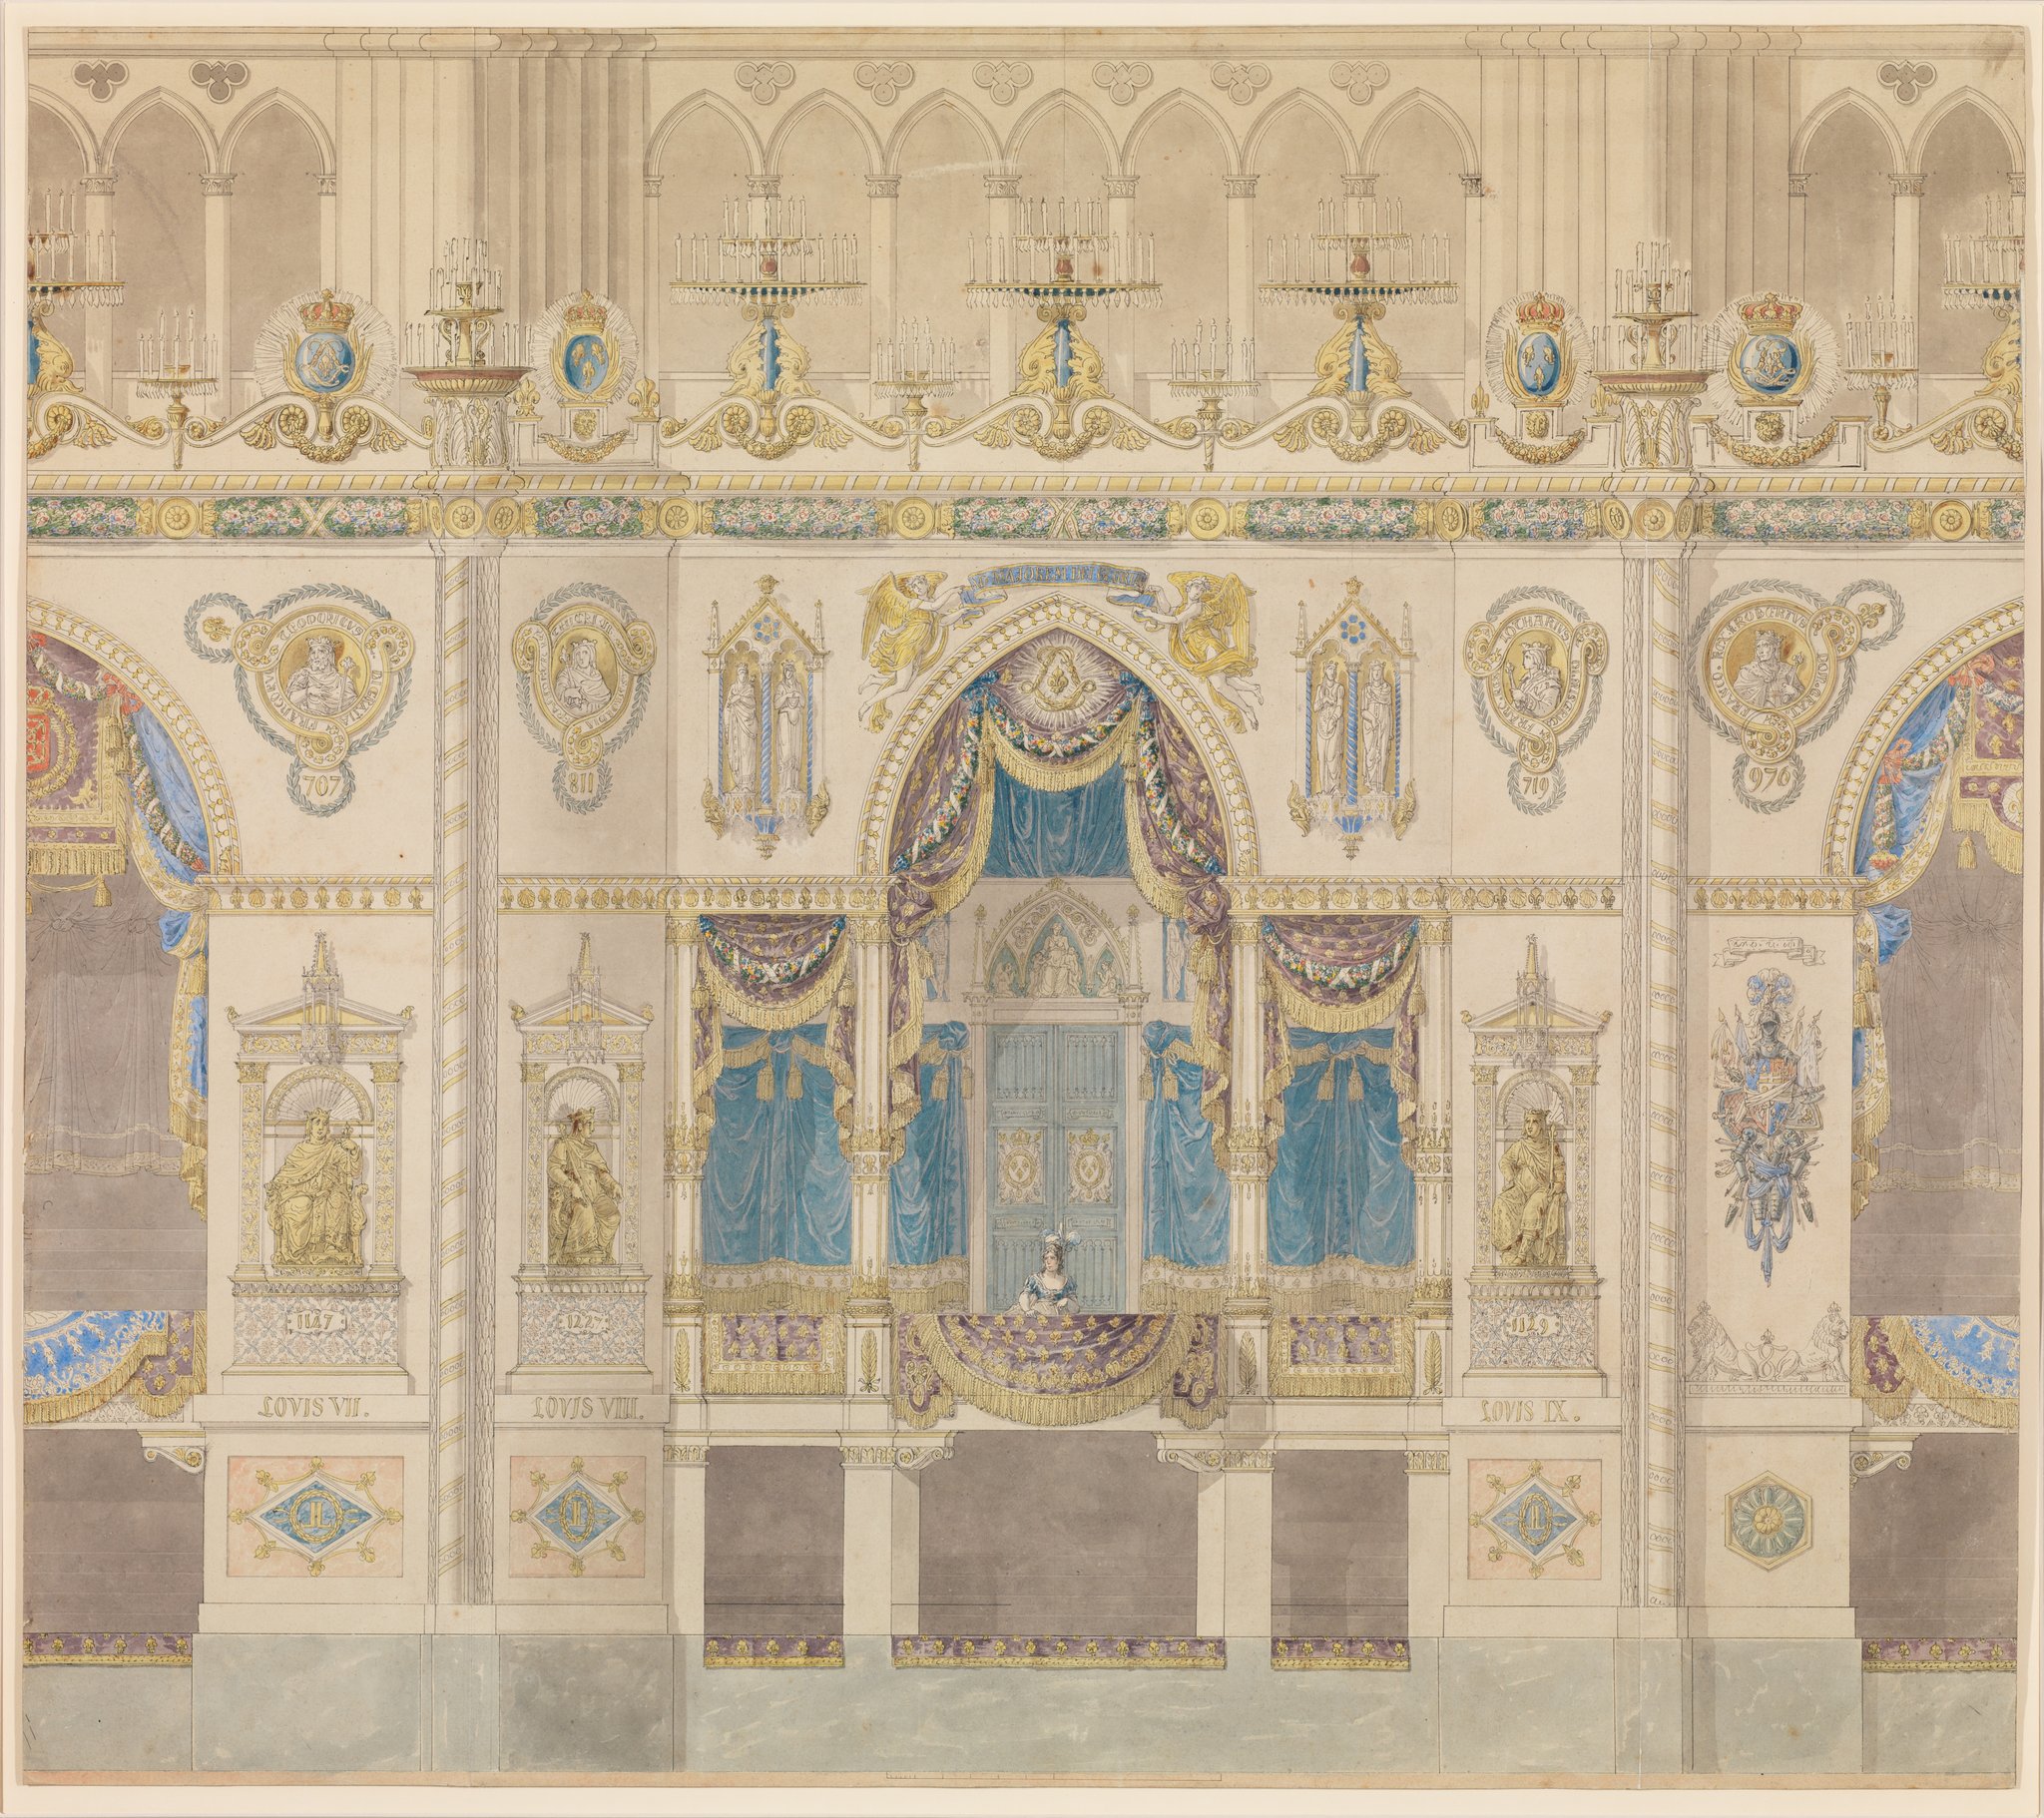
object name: drawing ornament architecture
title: Elevation of Reims Cathedral with the Royal Box for the Coronation of Louis XVIII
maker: charles percier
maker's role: designer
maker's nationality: french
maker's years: 1764-1838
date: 1815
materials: ink, watercolor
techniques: pen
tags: men,women,angels